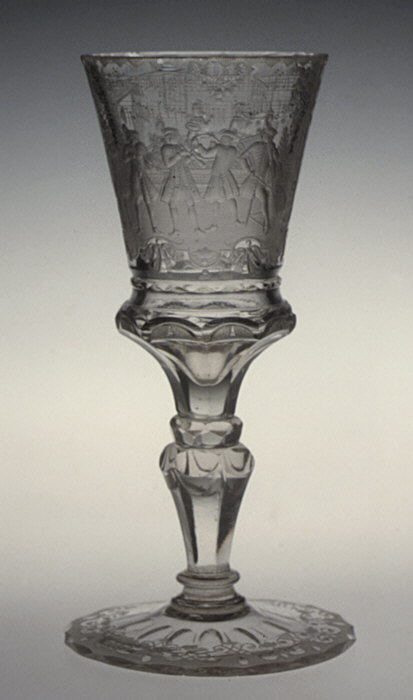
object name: standing cup with cover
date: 1725-1730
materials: glass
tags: musicians